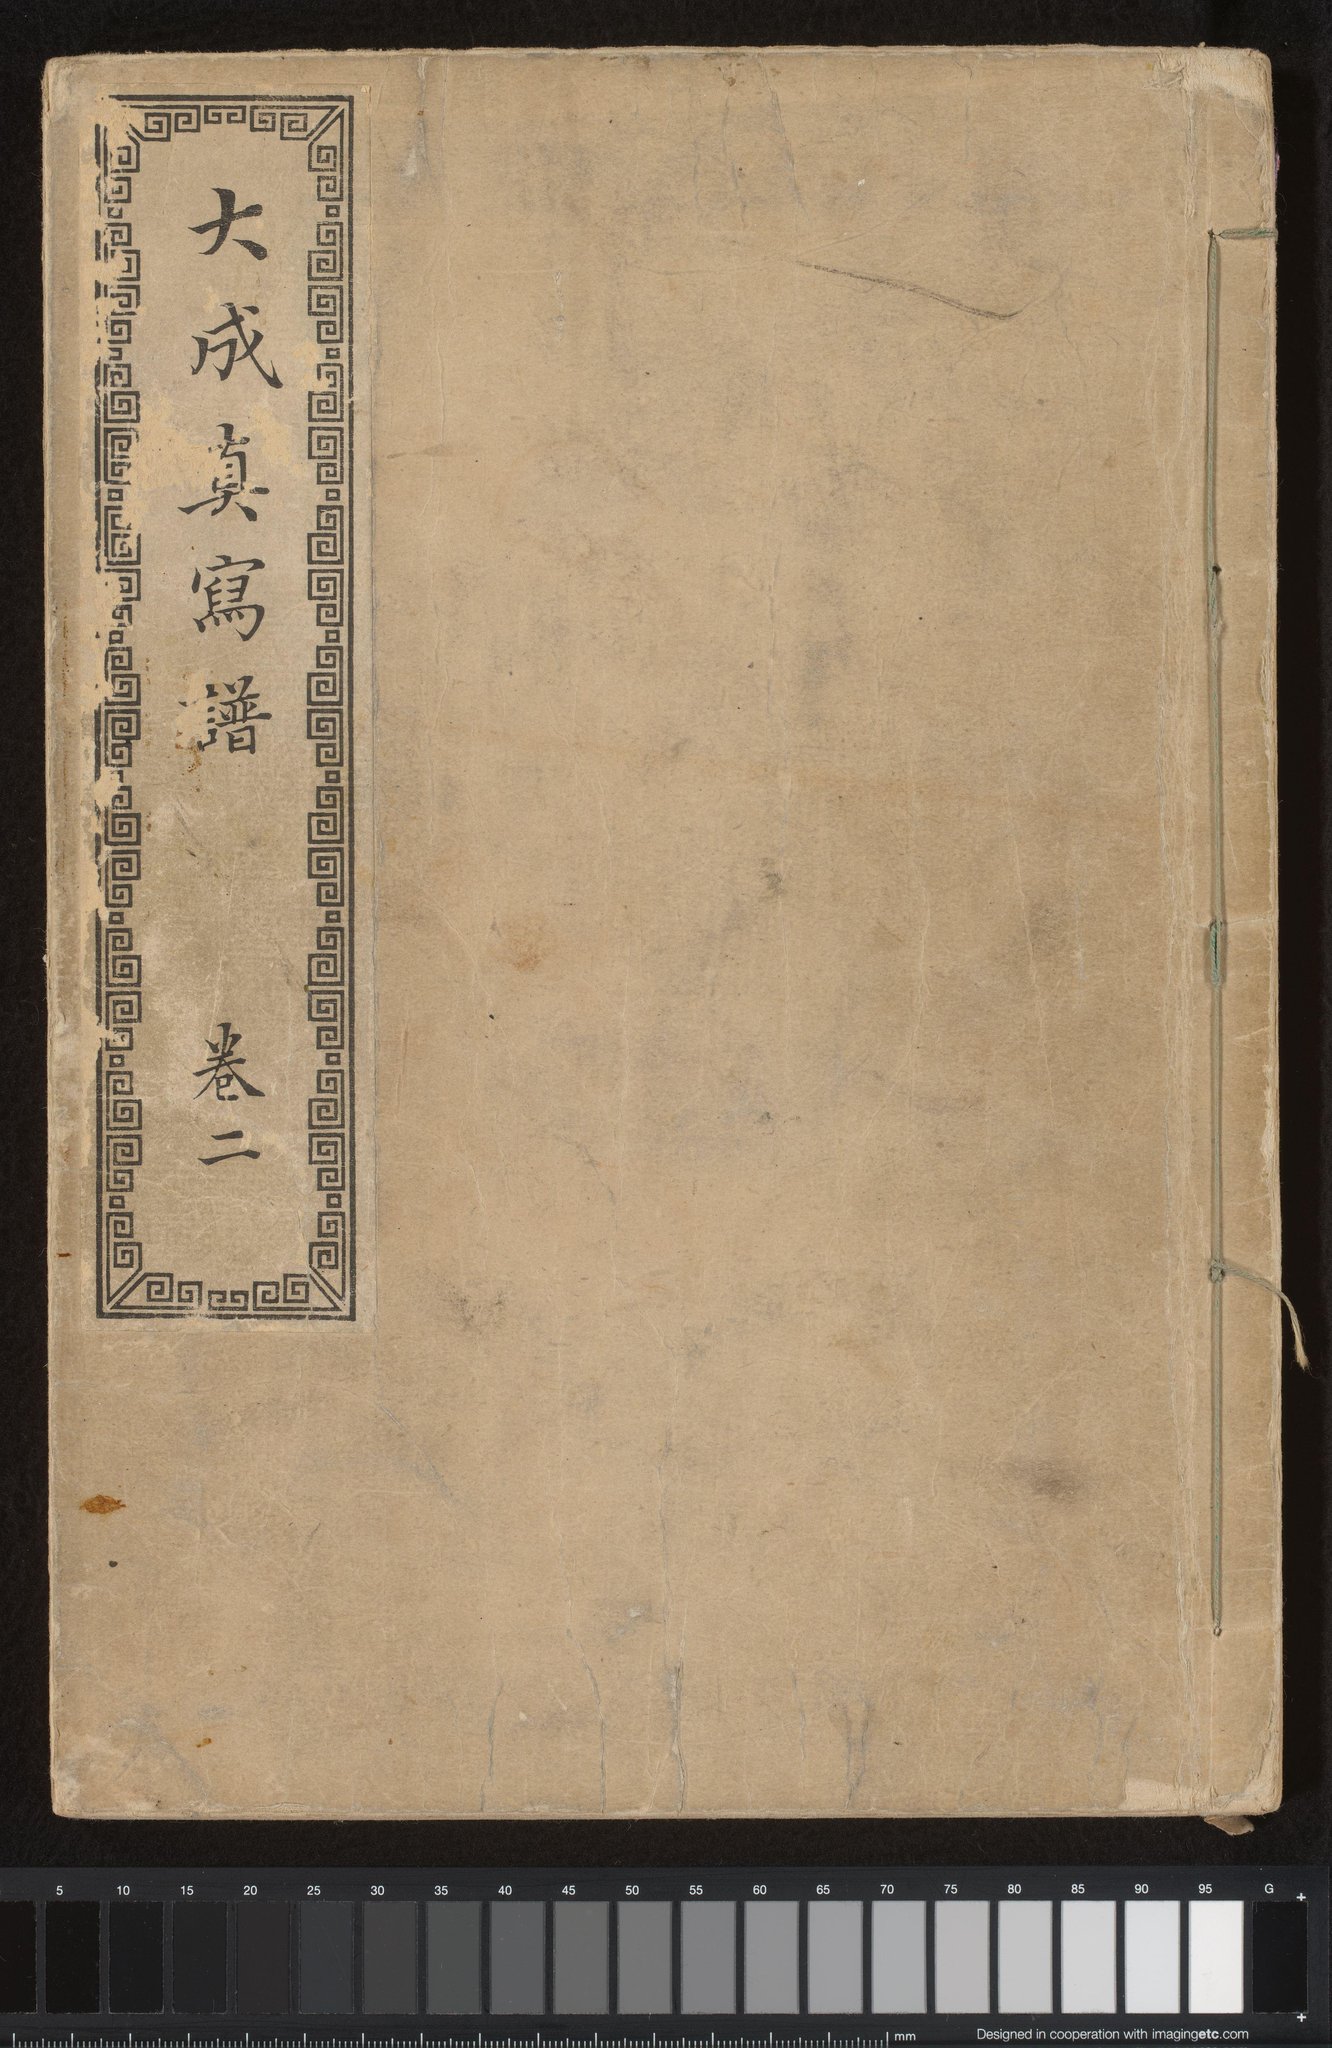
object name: book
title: Taisei shinshafu - ni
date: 1888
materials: paper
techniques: woodcut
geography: osaka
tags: flowers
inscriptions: collector's mark: Lugt 2228, collector's mark: ‘Rijksschool voor kunstnijverheid’ Lugt 3937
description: De titelstrook is verwisseld en geeft aan dat dit deel twee is; de tekst binnenin maakt duidelijk dat het om deel één gaat.